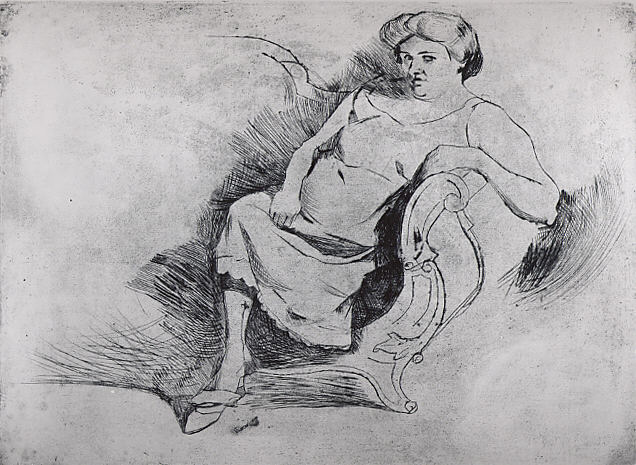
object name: print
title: Gisella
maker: umberto boccioni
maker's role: artist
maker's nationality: italian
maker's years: 1882-1916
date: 1907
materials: ink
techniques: drypoint, printing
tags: portraits,women